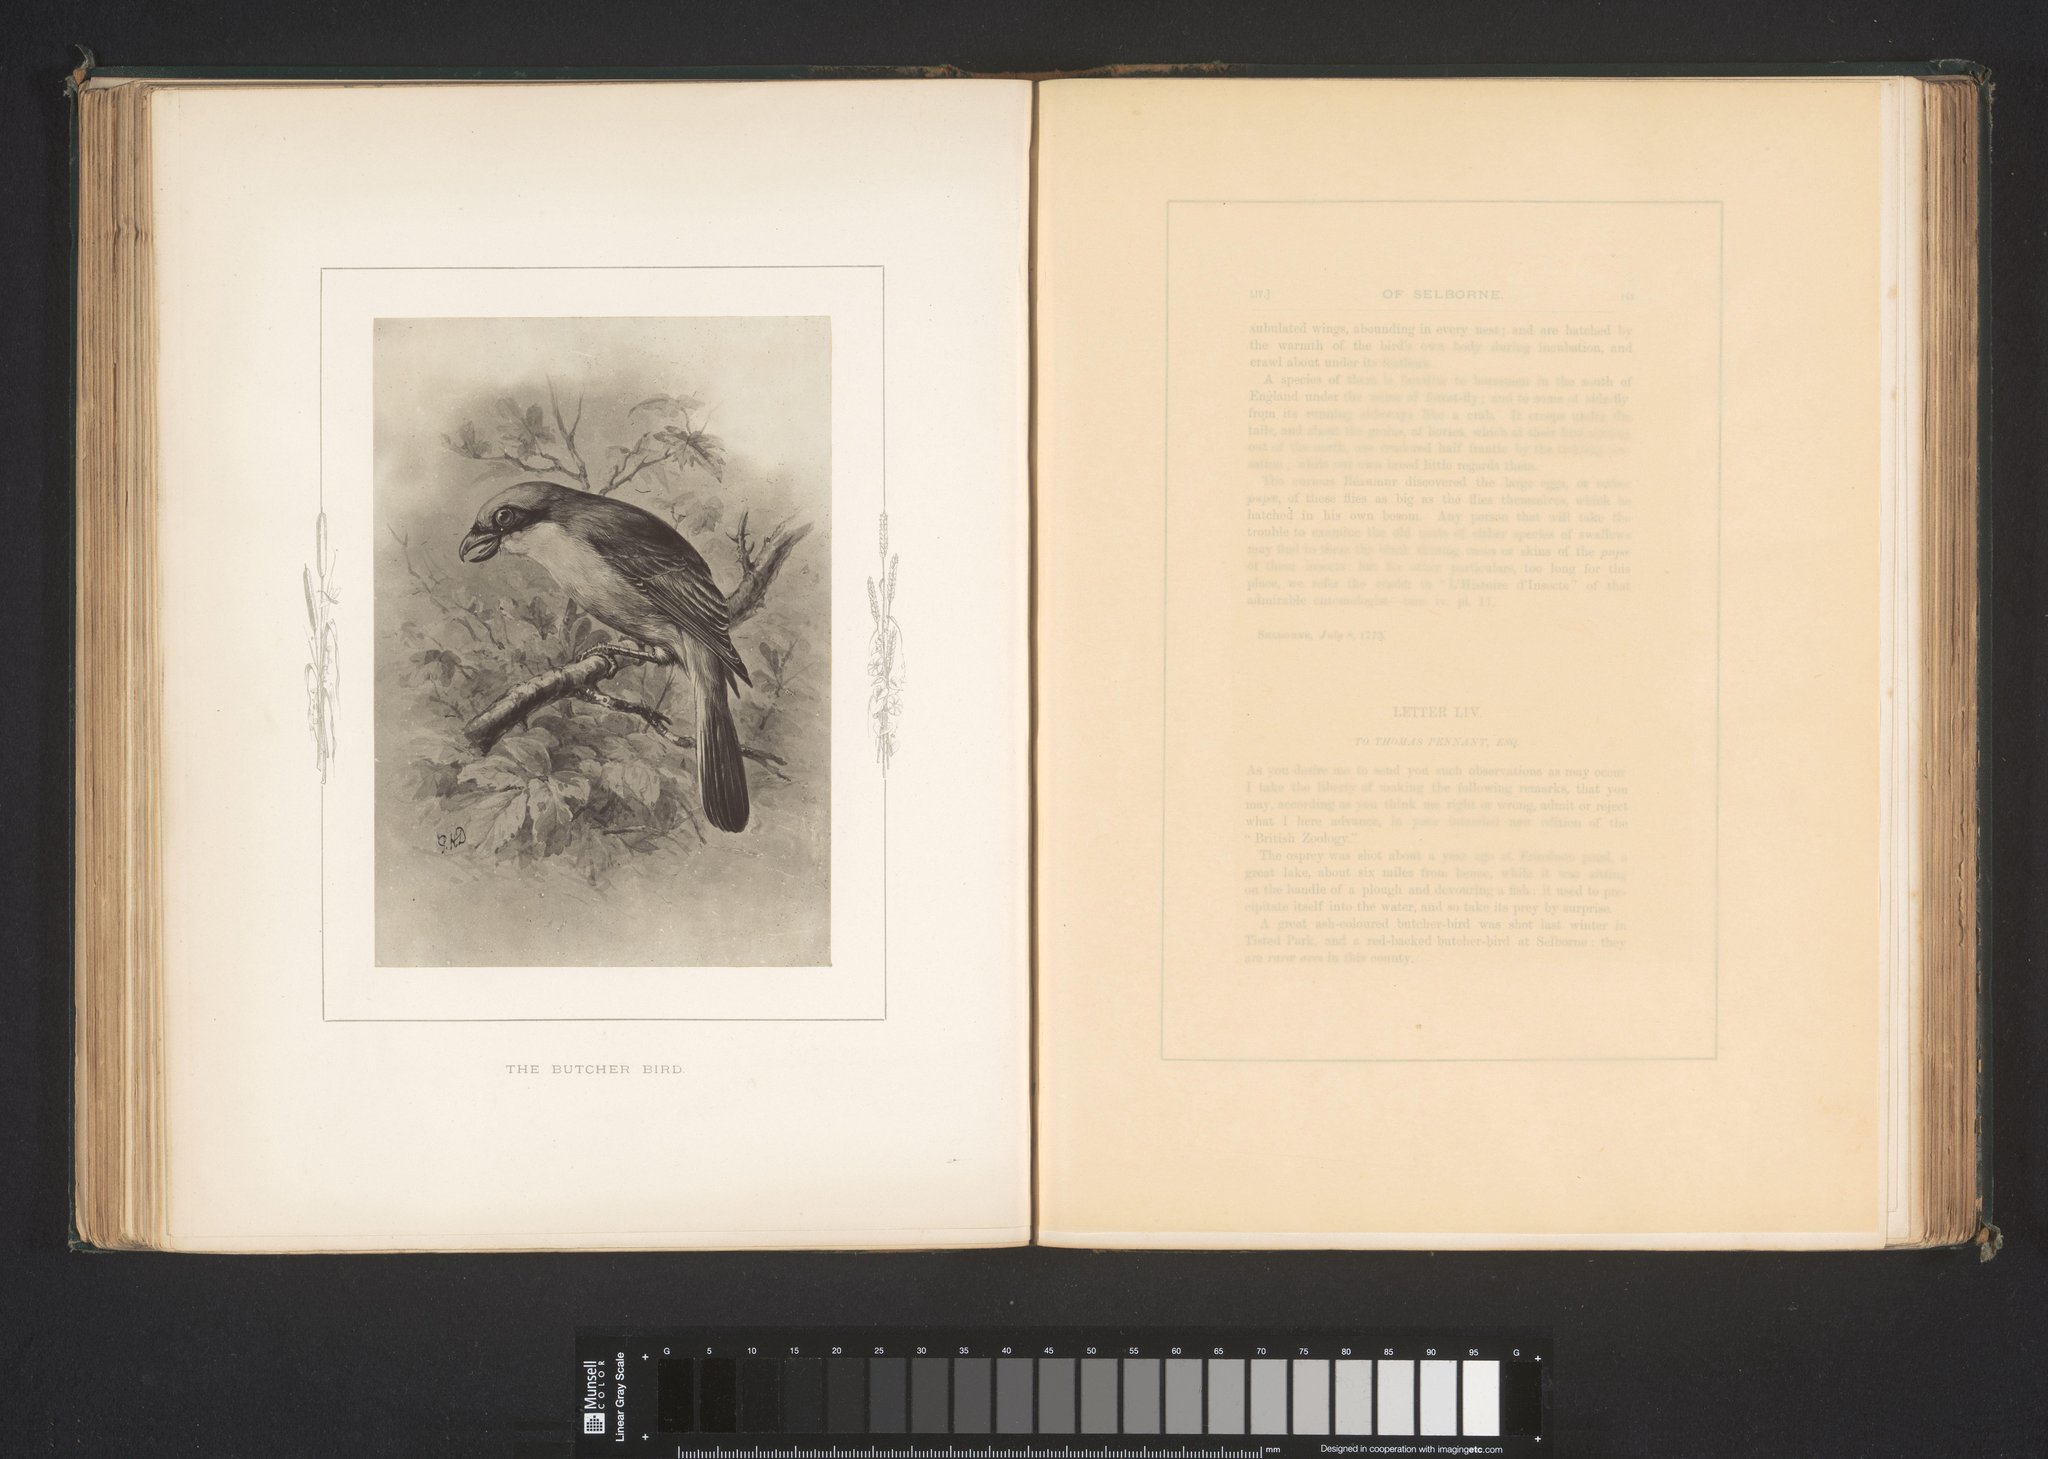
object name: page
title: The butcher bird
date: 1850-1876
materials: photographic support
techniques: carbon print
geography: selborne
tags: birds